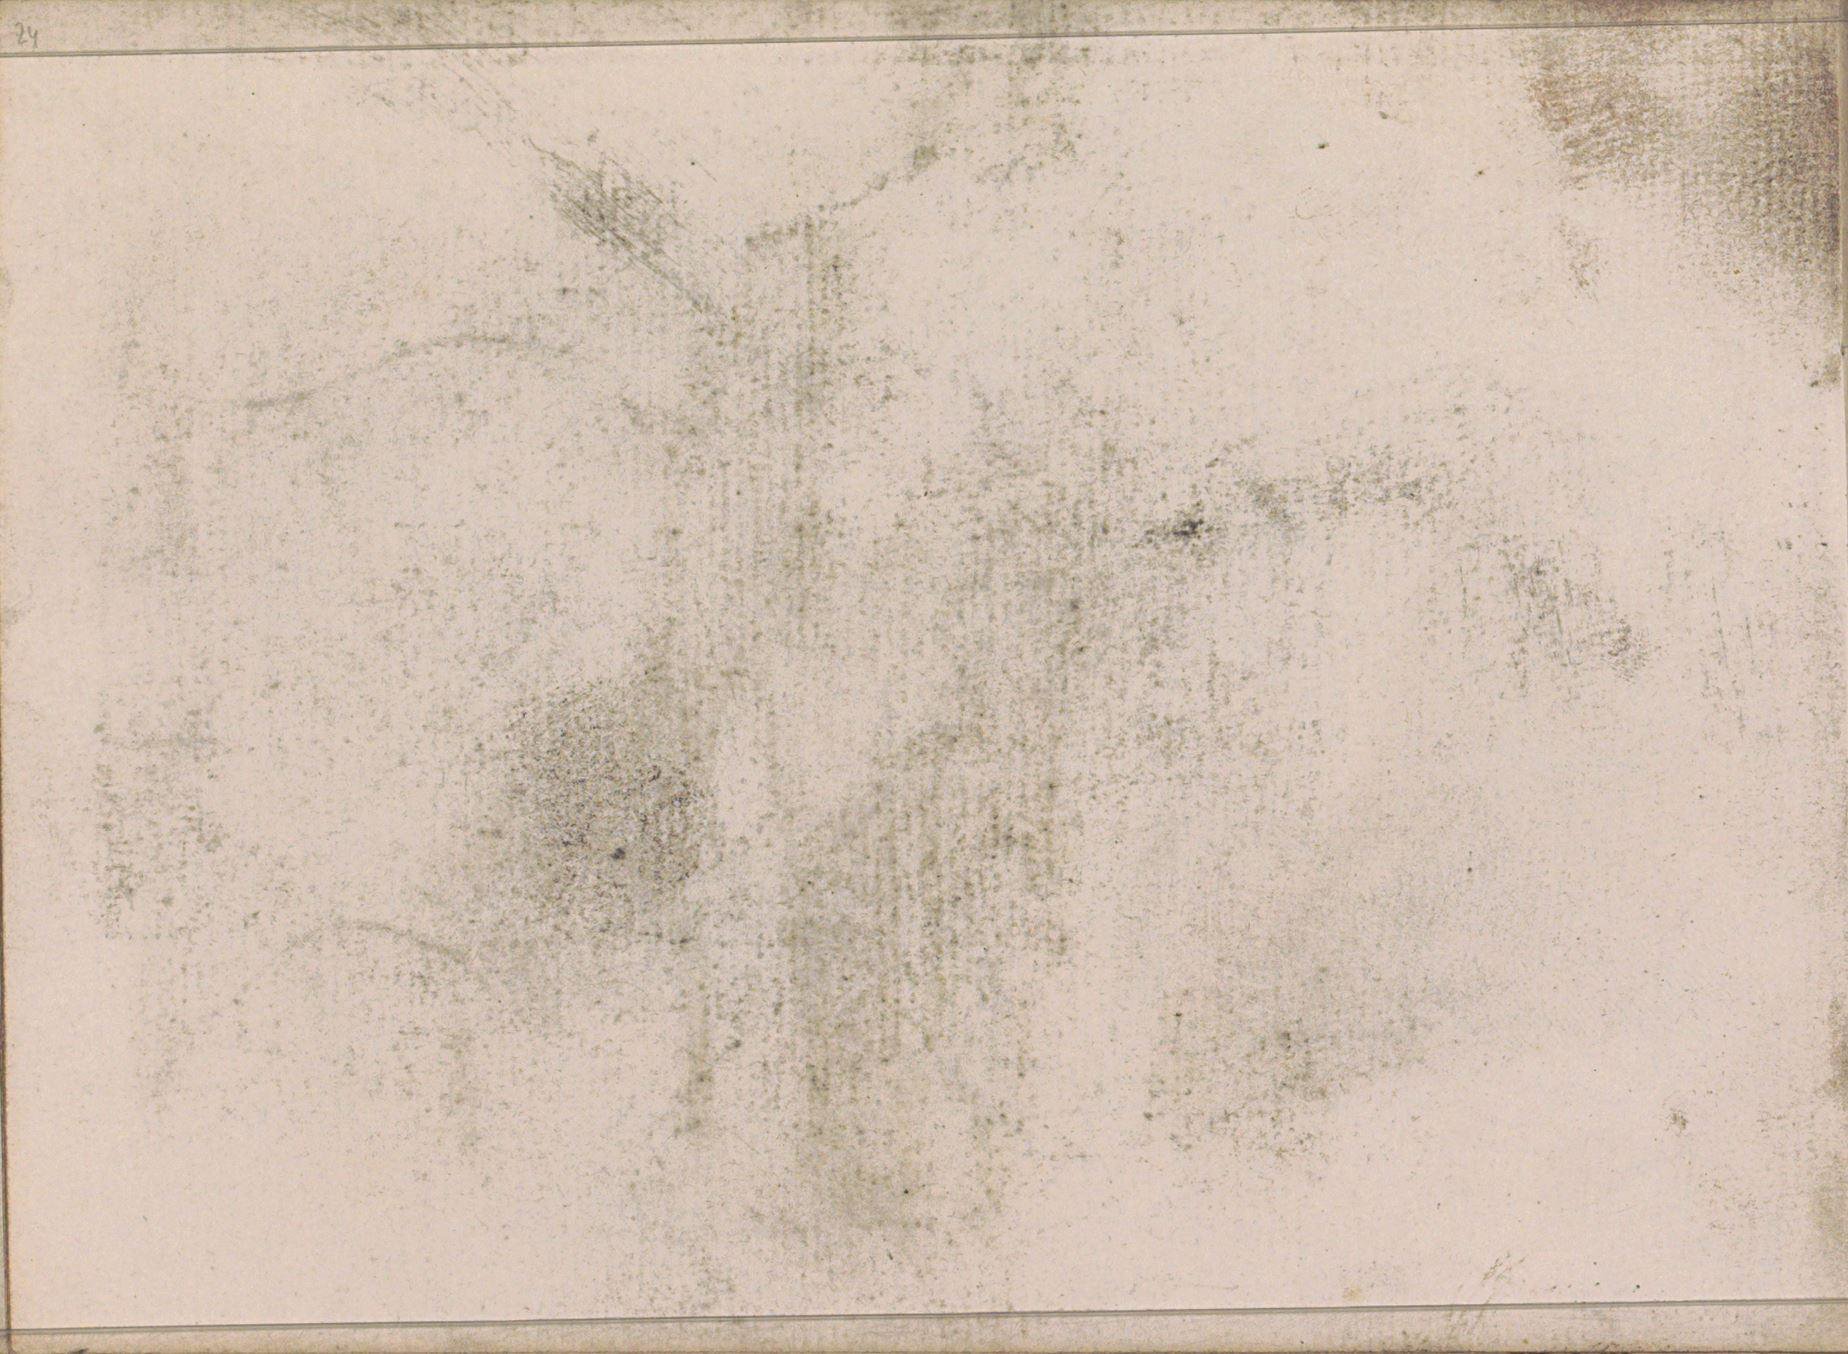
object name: sketchbook leaf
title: Abklatsch van de krijttekening op pagina 25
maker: isaac israels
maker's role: draughtsman, painter, print maker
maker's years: 1865-1934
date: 1886-1903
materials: paper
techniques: printmaking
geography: amsterdam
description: Pagina 24 uit schetsboek XLVII met 52 pagina's.